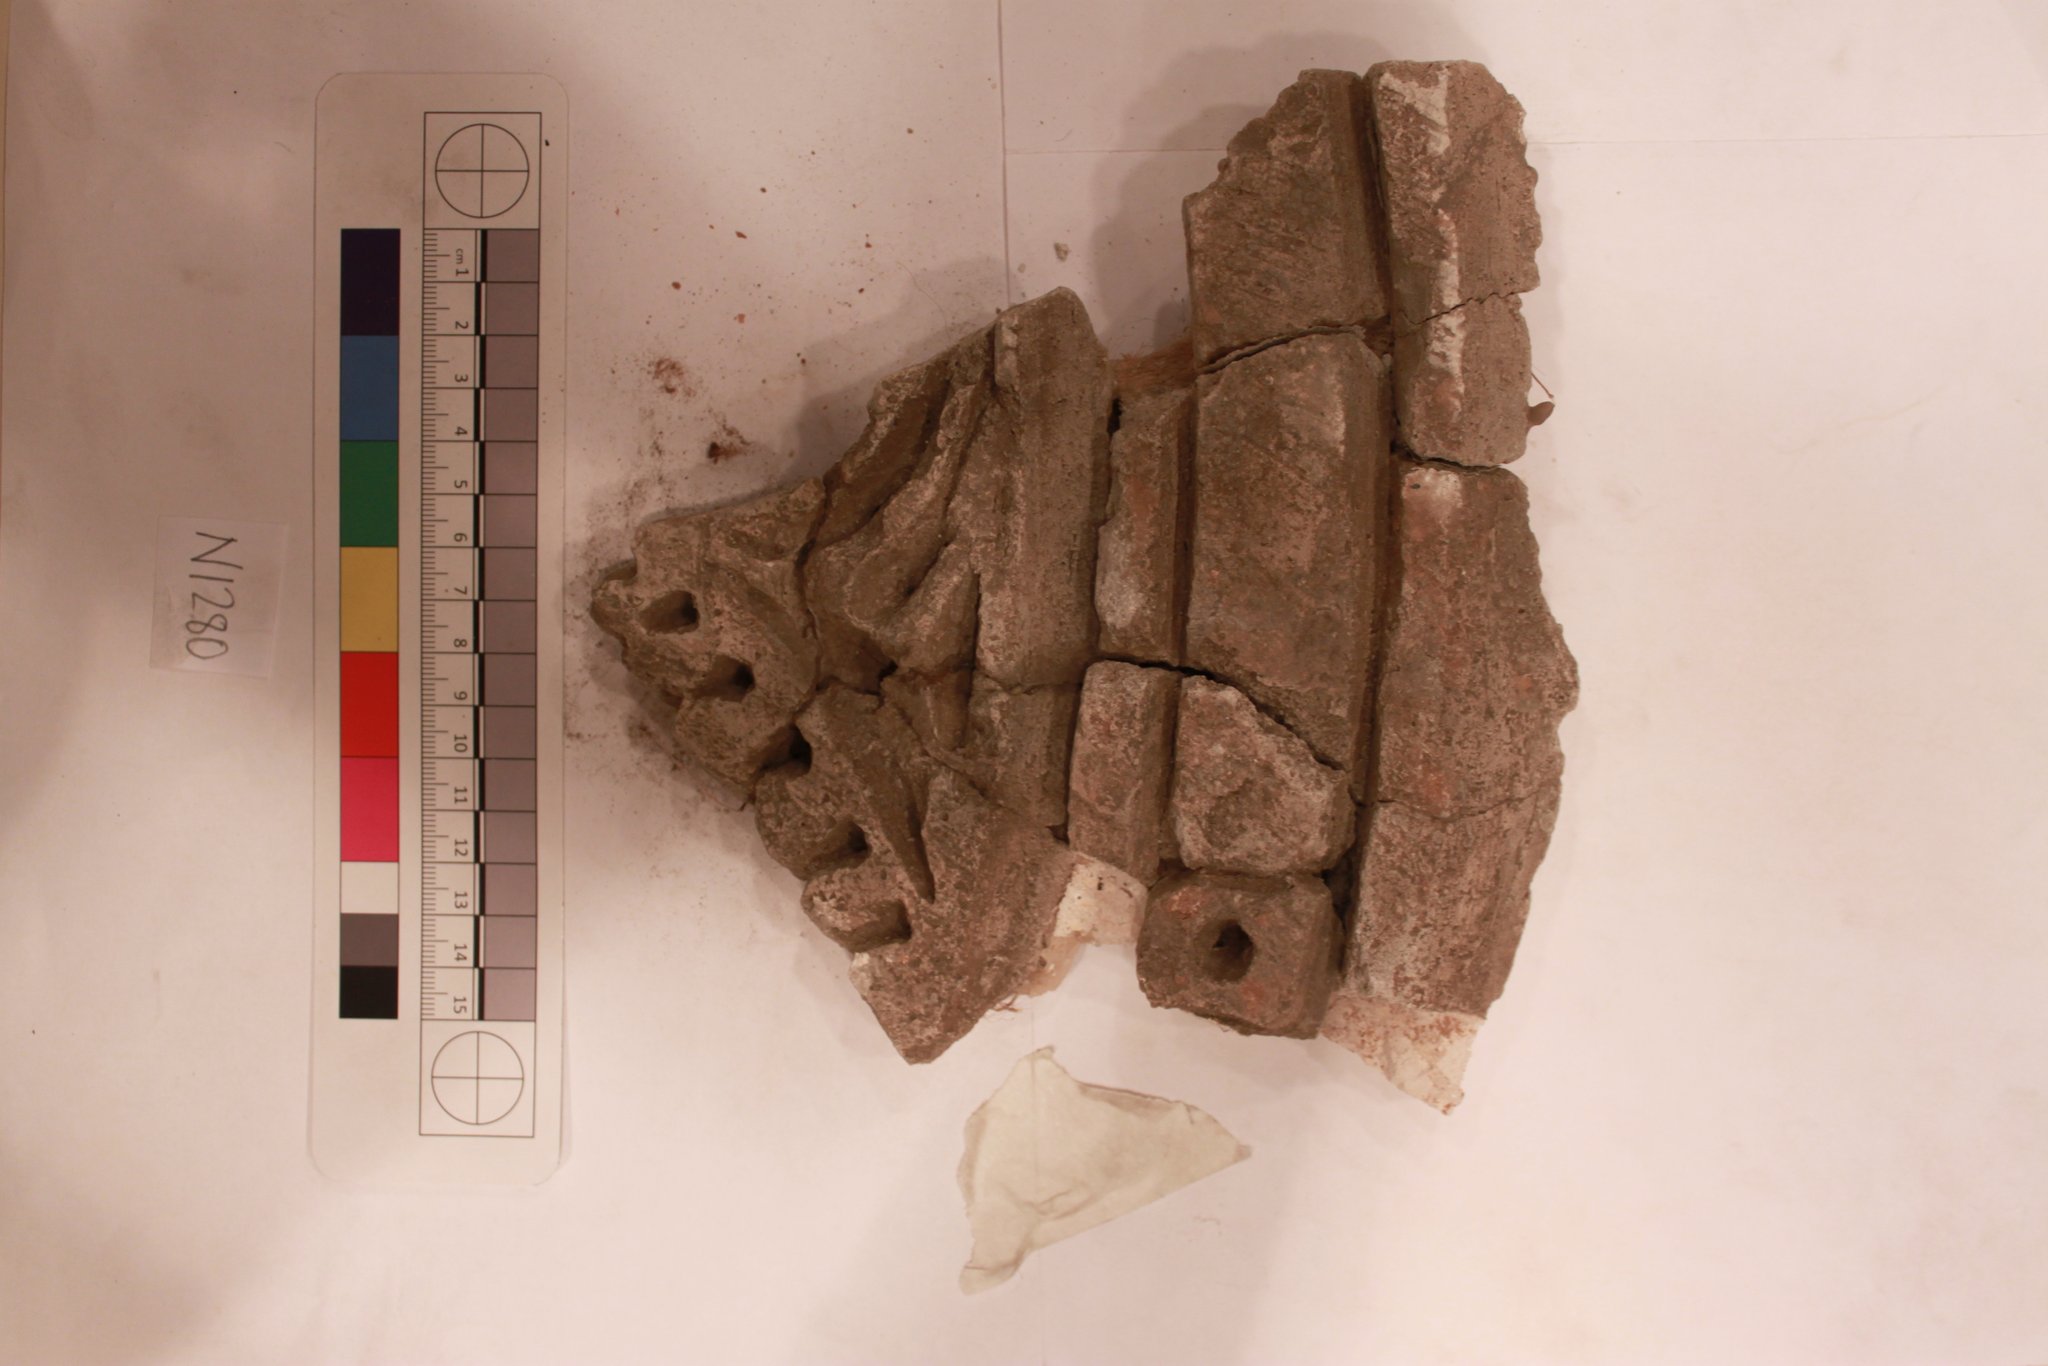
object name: fragment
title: Stucco Fragment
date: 701-1200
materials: plaster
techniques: carving, painting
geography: iran